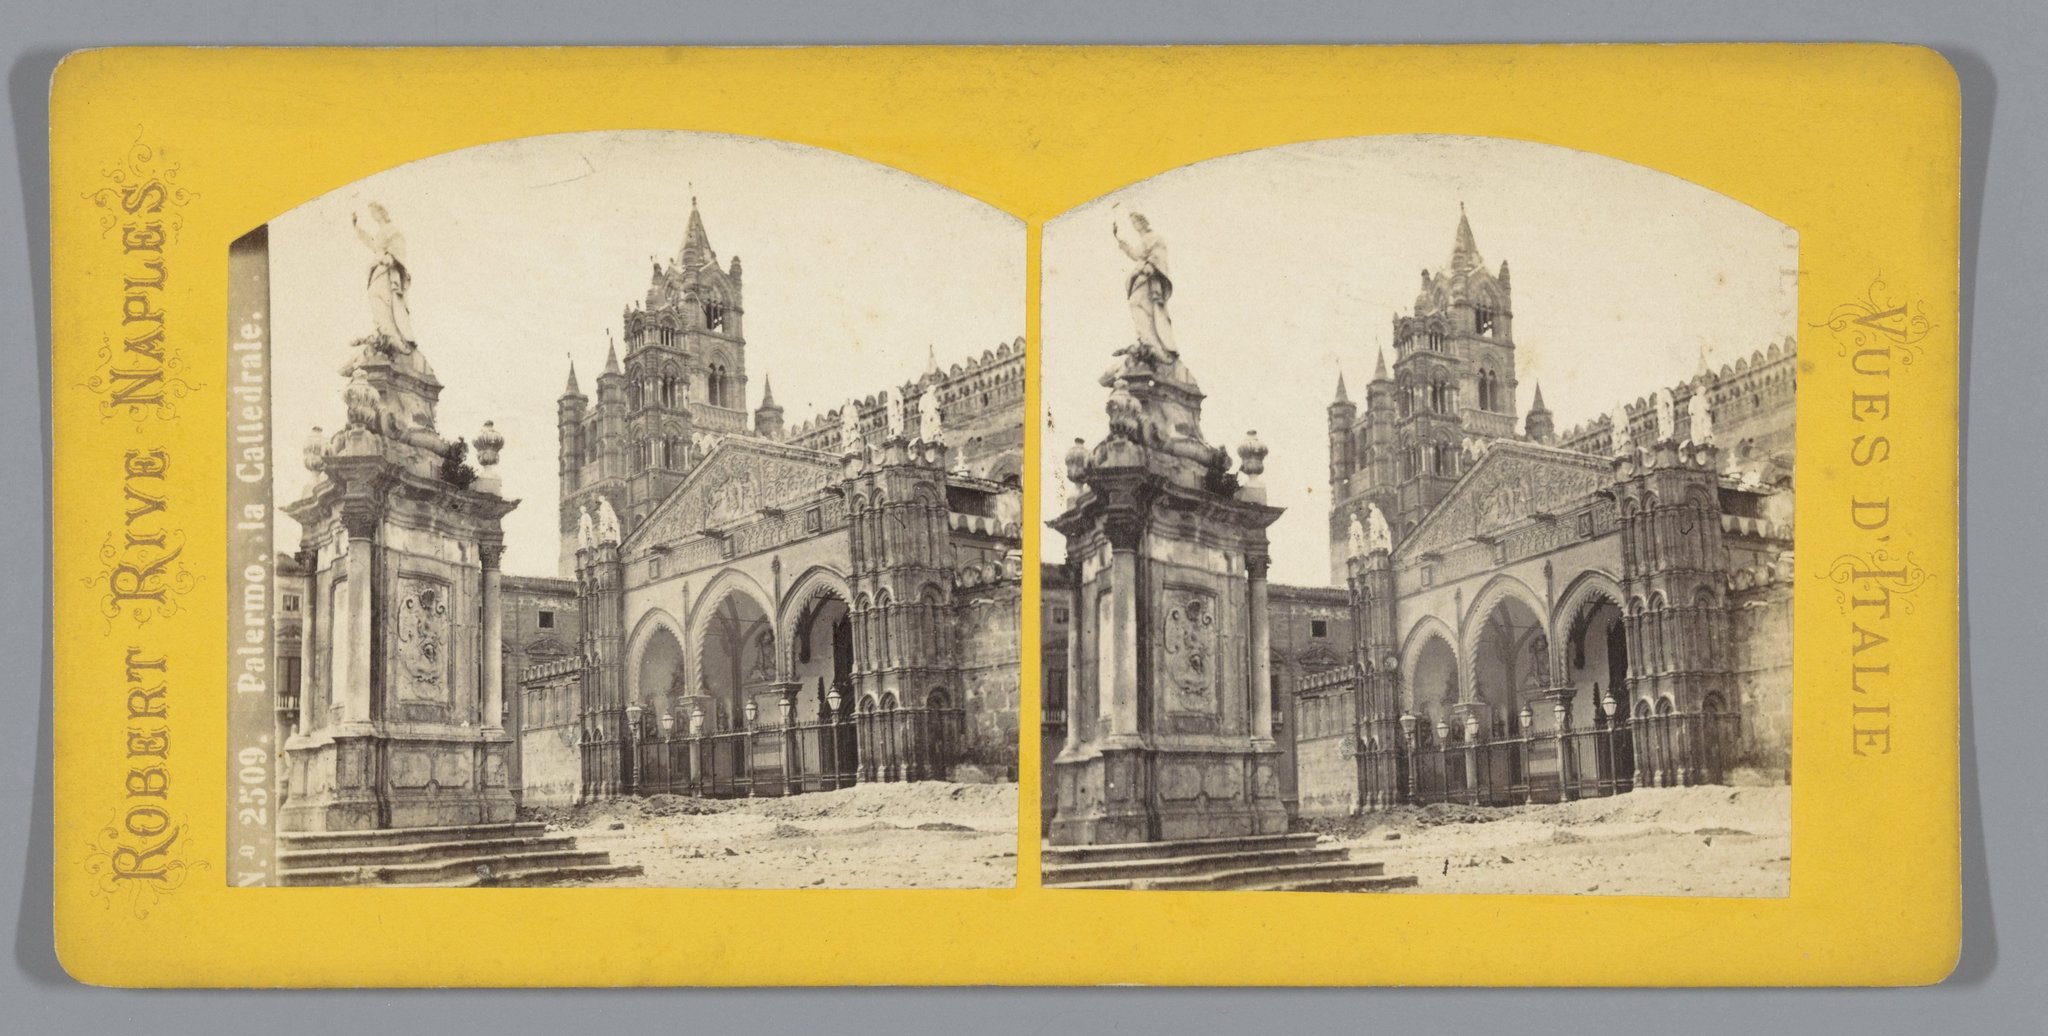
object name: stereograph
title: Vues d'Italie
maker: roberto rive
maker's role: fotograaf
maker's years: 1825-1868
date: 1860-1880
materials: cardboard, photographic support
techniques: albumen print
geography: palermo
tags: church (exterior)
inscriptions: number: ‘No. 2509.’